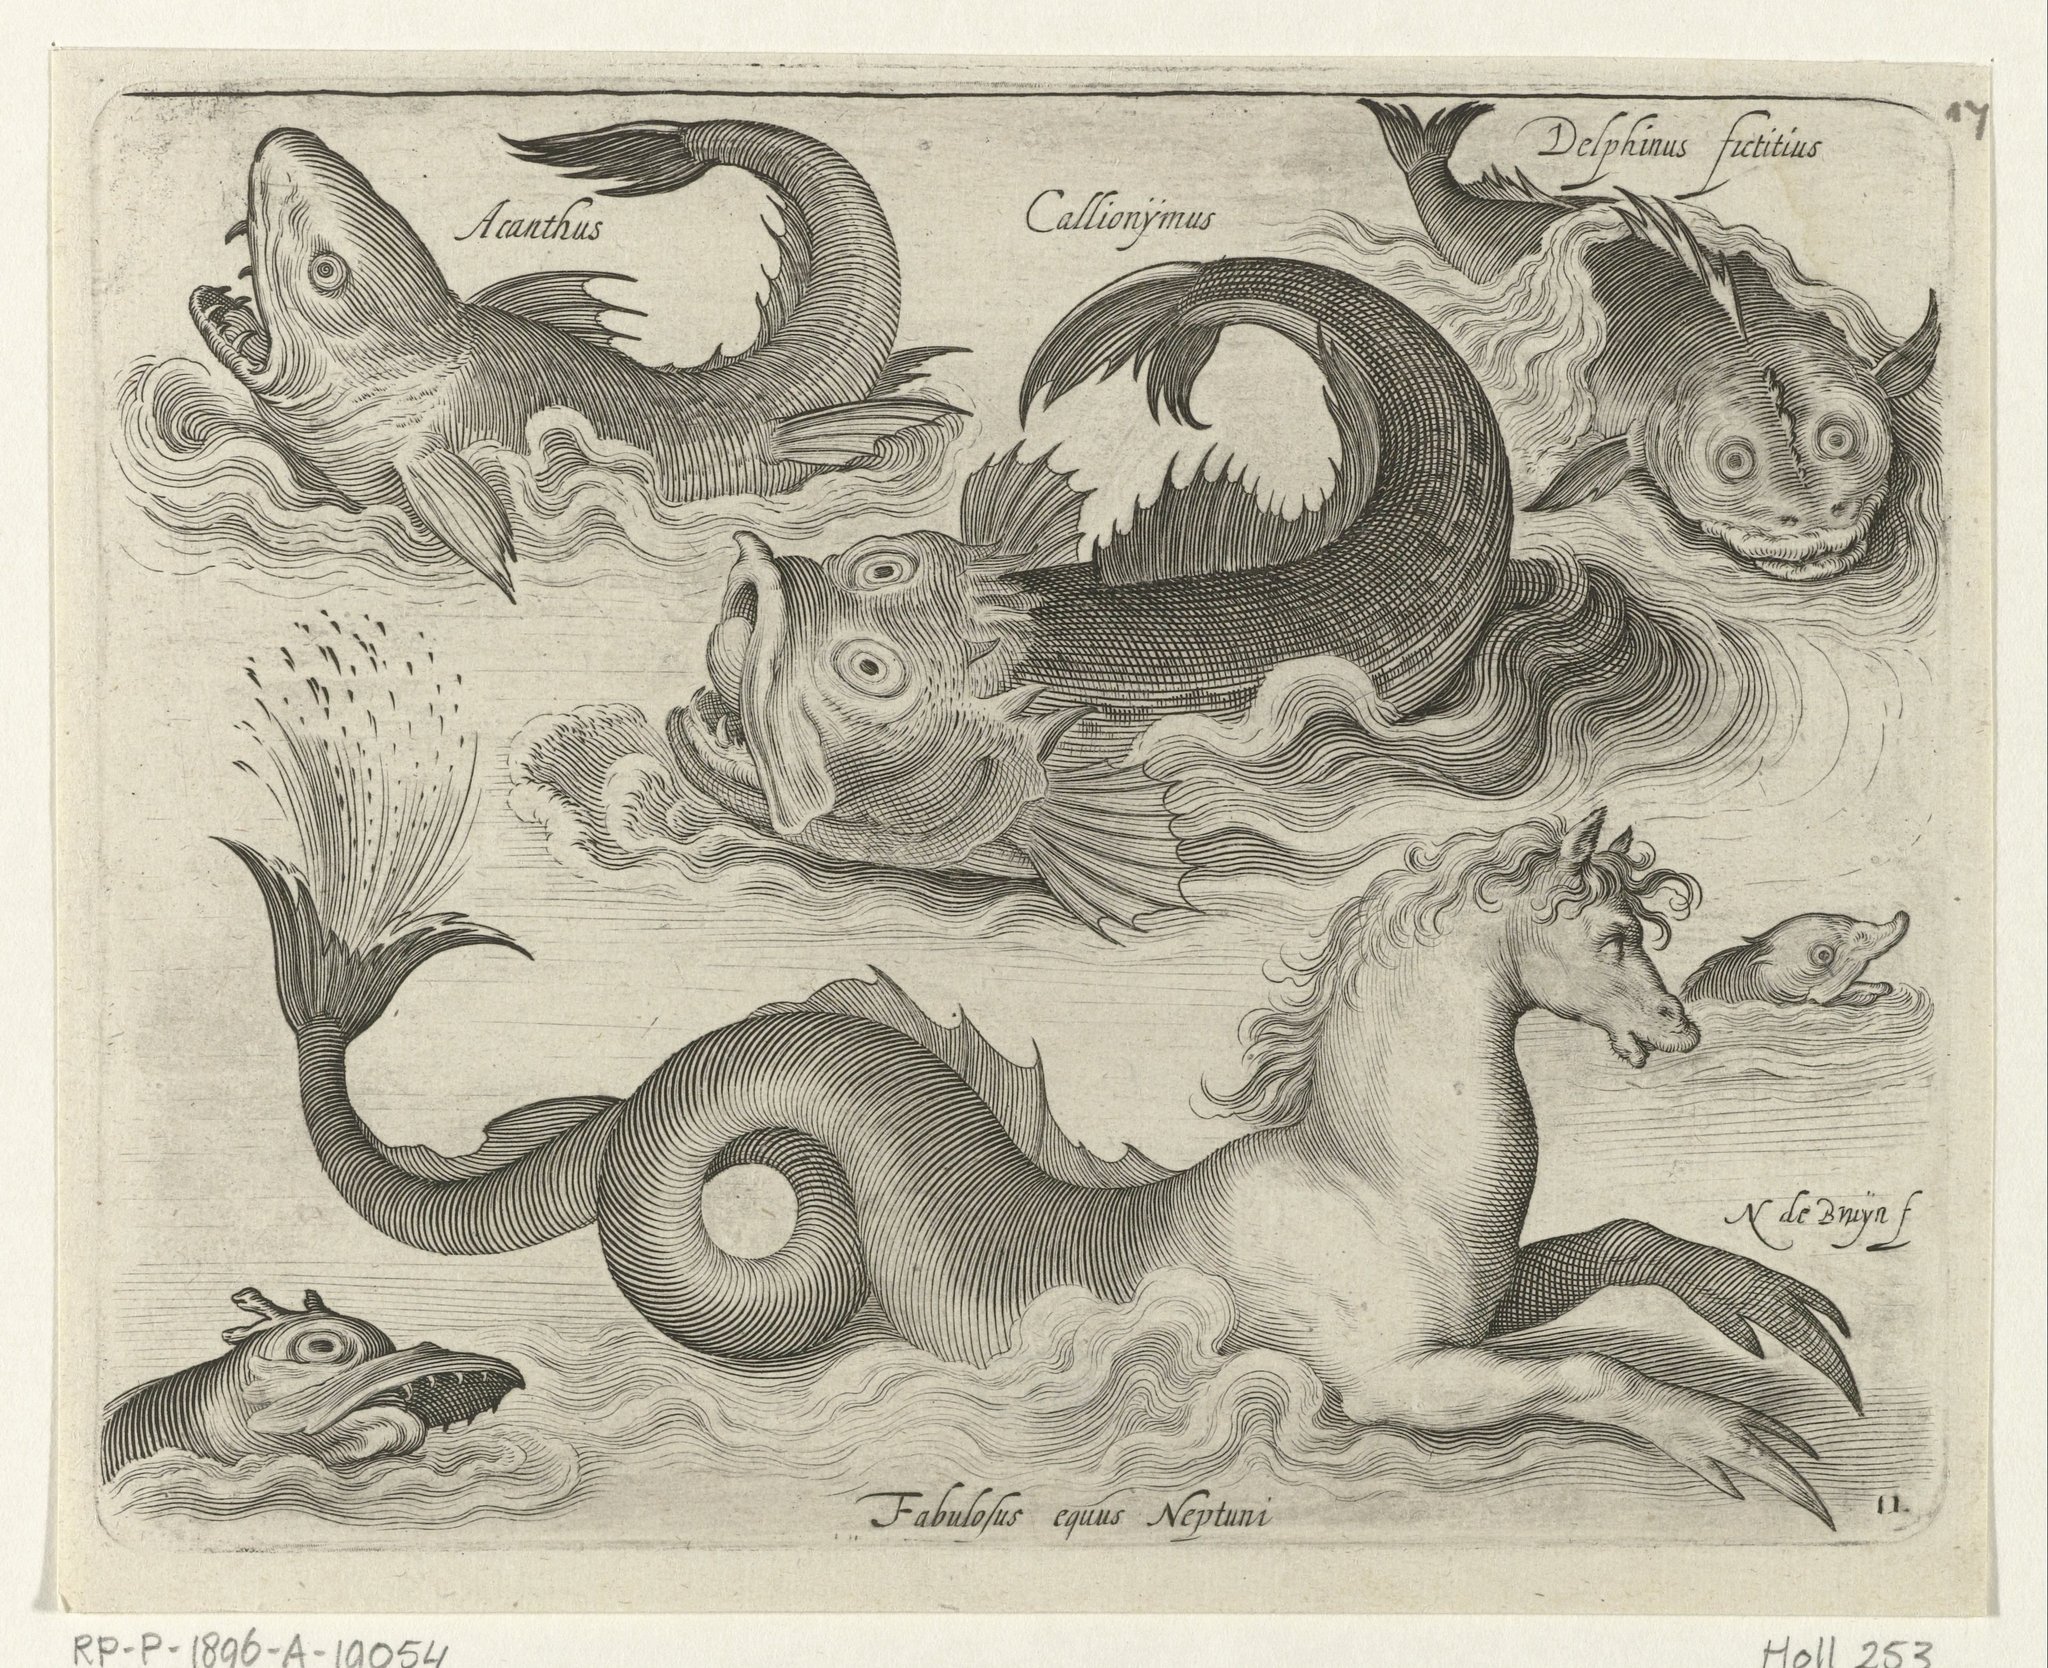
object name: print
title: Fantastische waterdieren, onder andere zeepaard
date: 1581-1656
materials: paper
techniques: engraving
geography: netherlands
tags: sea-horse, hippocamp, 'hippocampus', (horse/fish) (mythological hybrid monster), fabulous animals ~ fishes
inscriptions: collector's mark: Lugt 2228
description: Prent uit serie Libelivs varia Genera piscium complectens van dertien prenten met zoetwatervissen, zeevissen, kikkers, schaaldieren en zeewezens (inclusief titelprent). Vermoedelijk ging een uitgave van Assuerus van Londerseel vooraf aan deze editie van Francoys van Beusekom, zie De Groot 1988, p. 38.